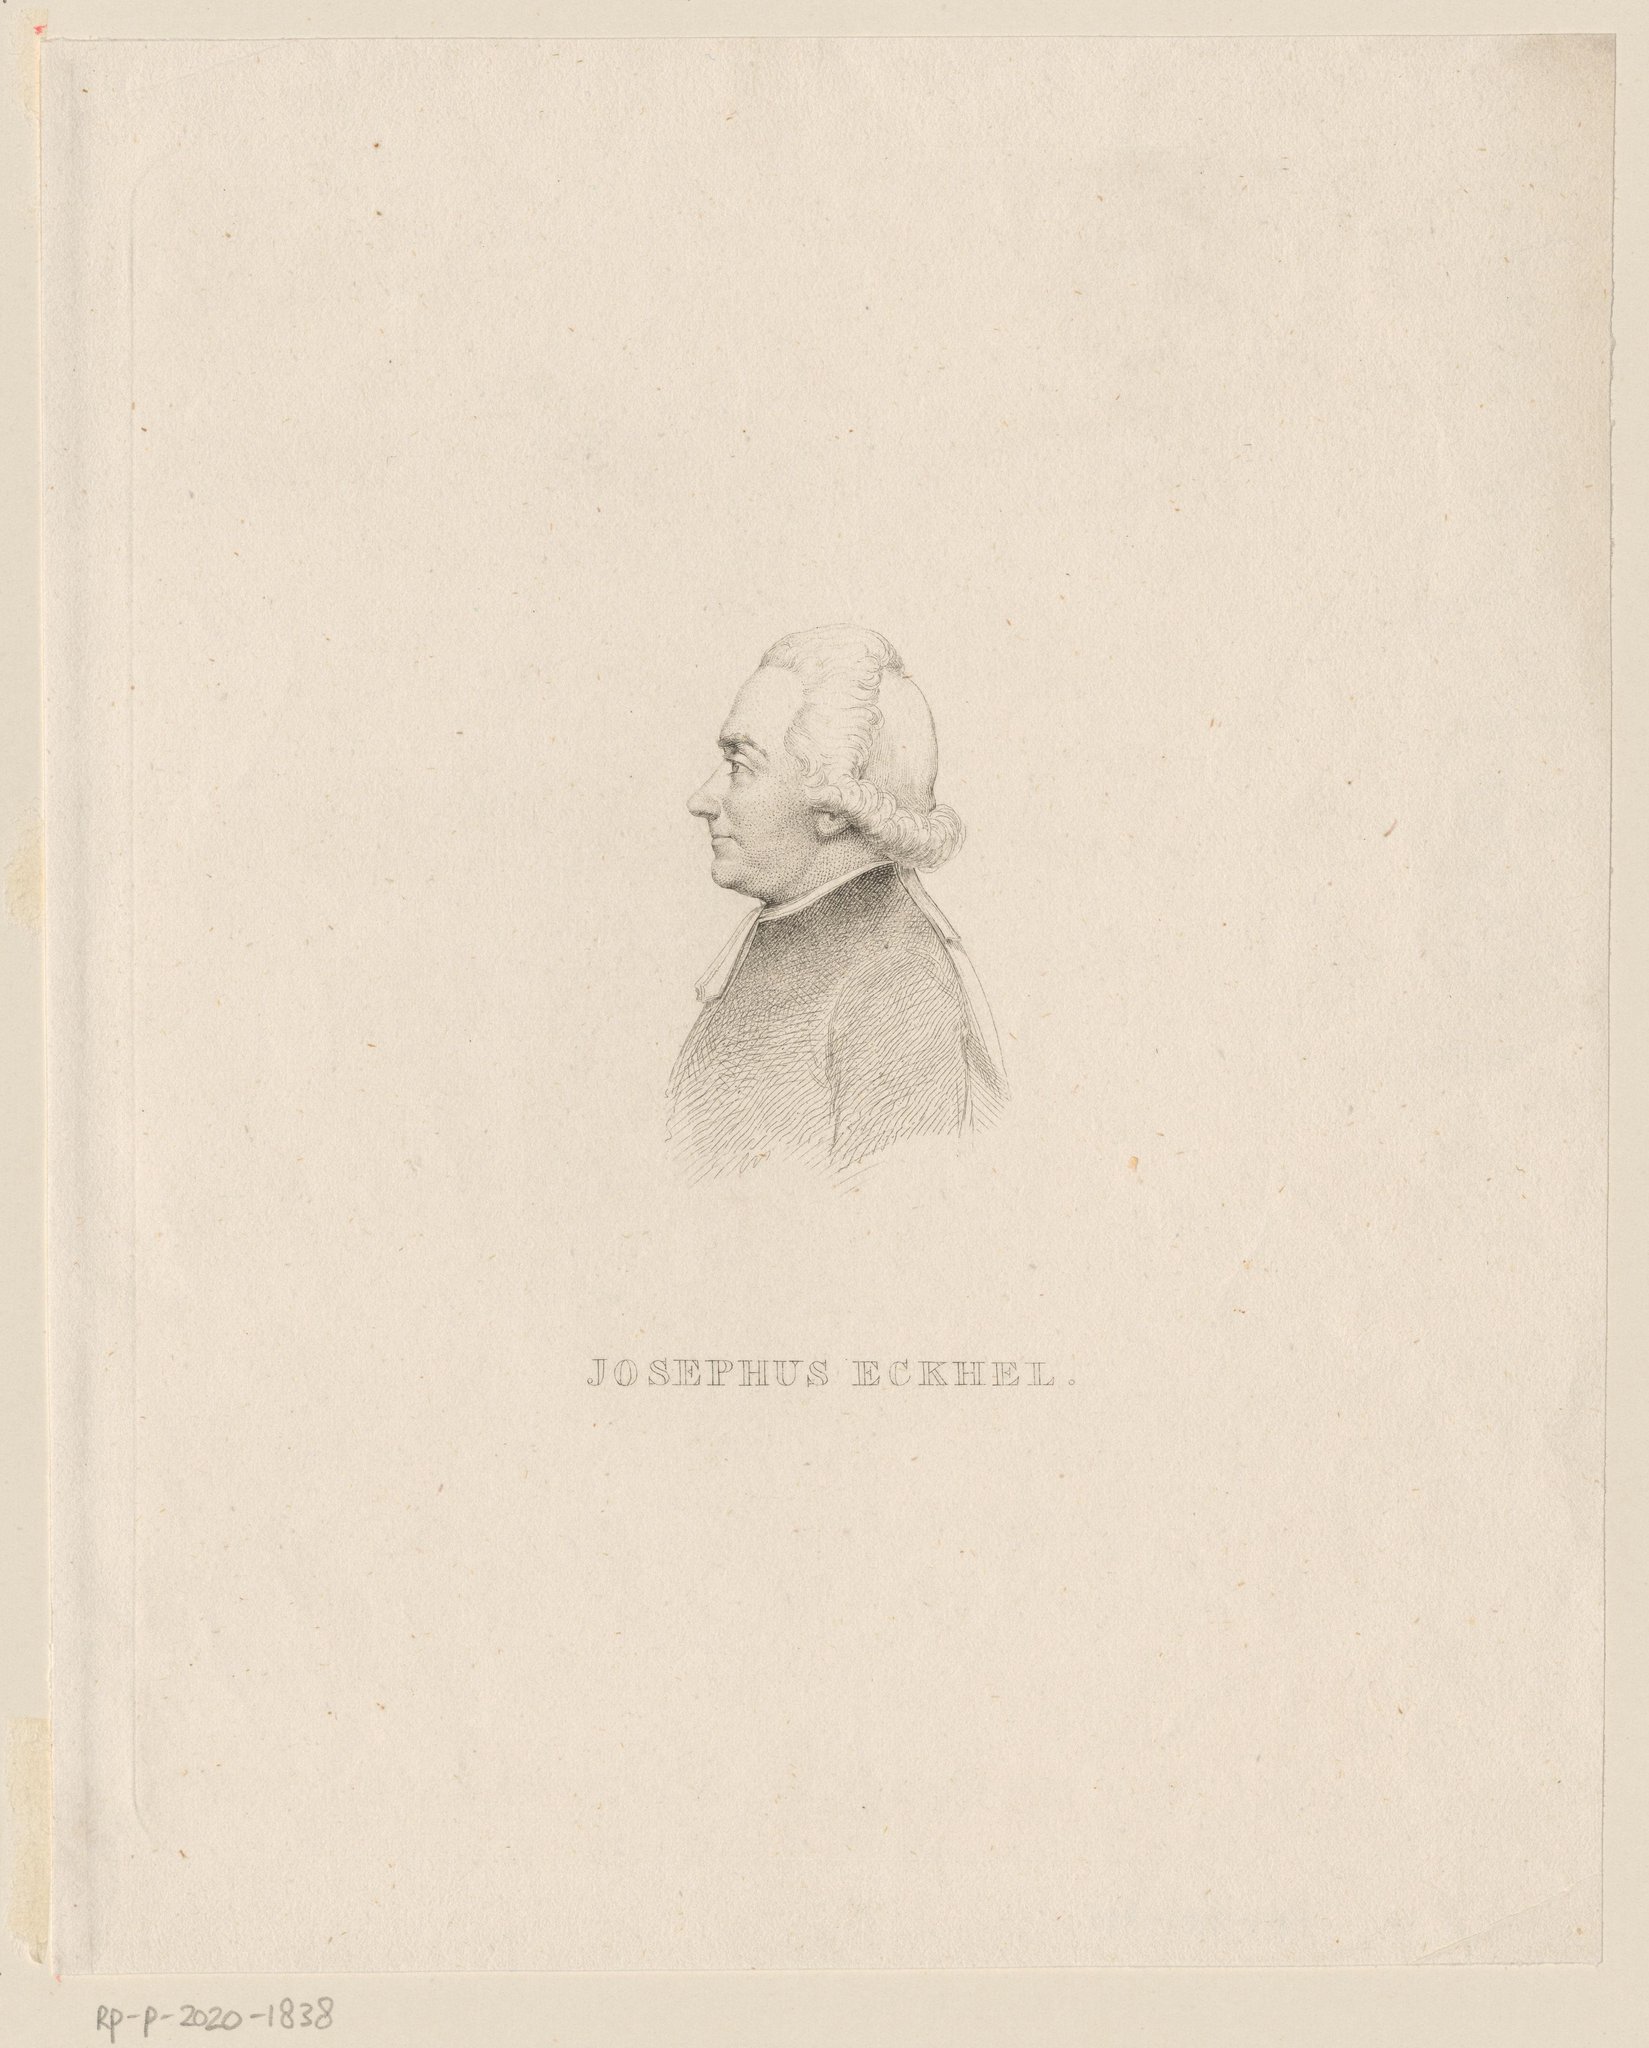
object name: print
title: Portret van Joseph Hilarius Eckhel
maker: Anonymous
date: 1770-1850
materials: paper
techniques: etching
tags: vienna, historical persons